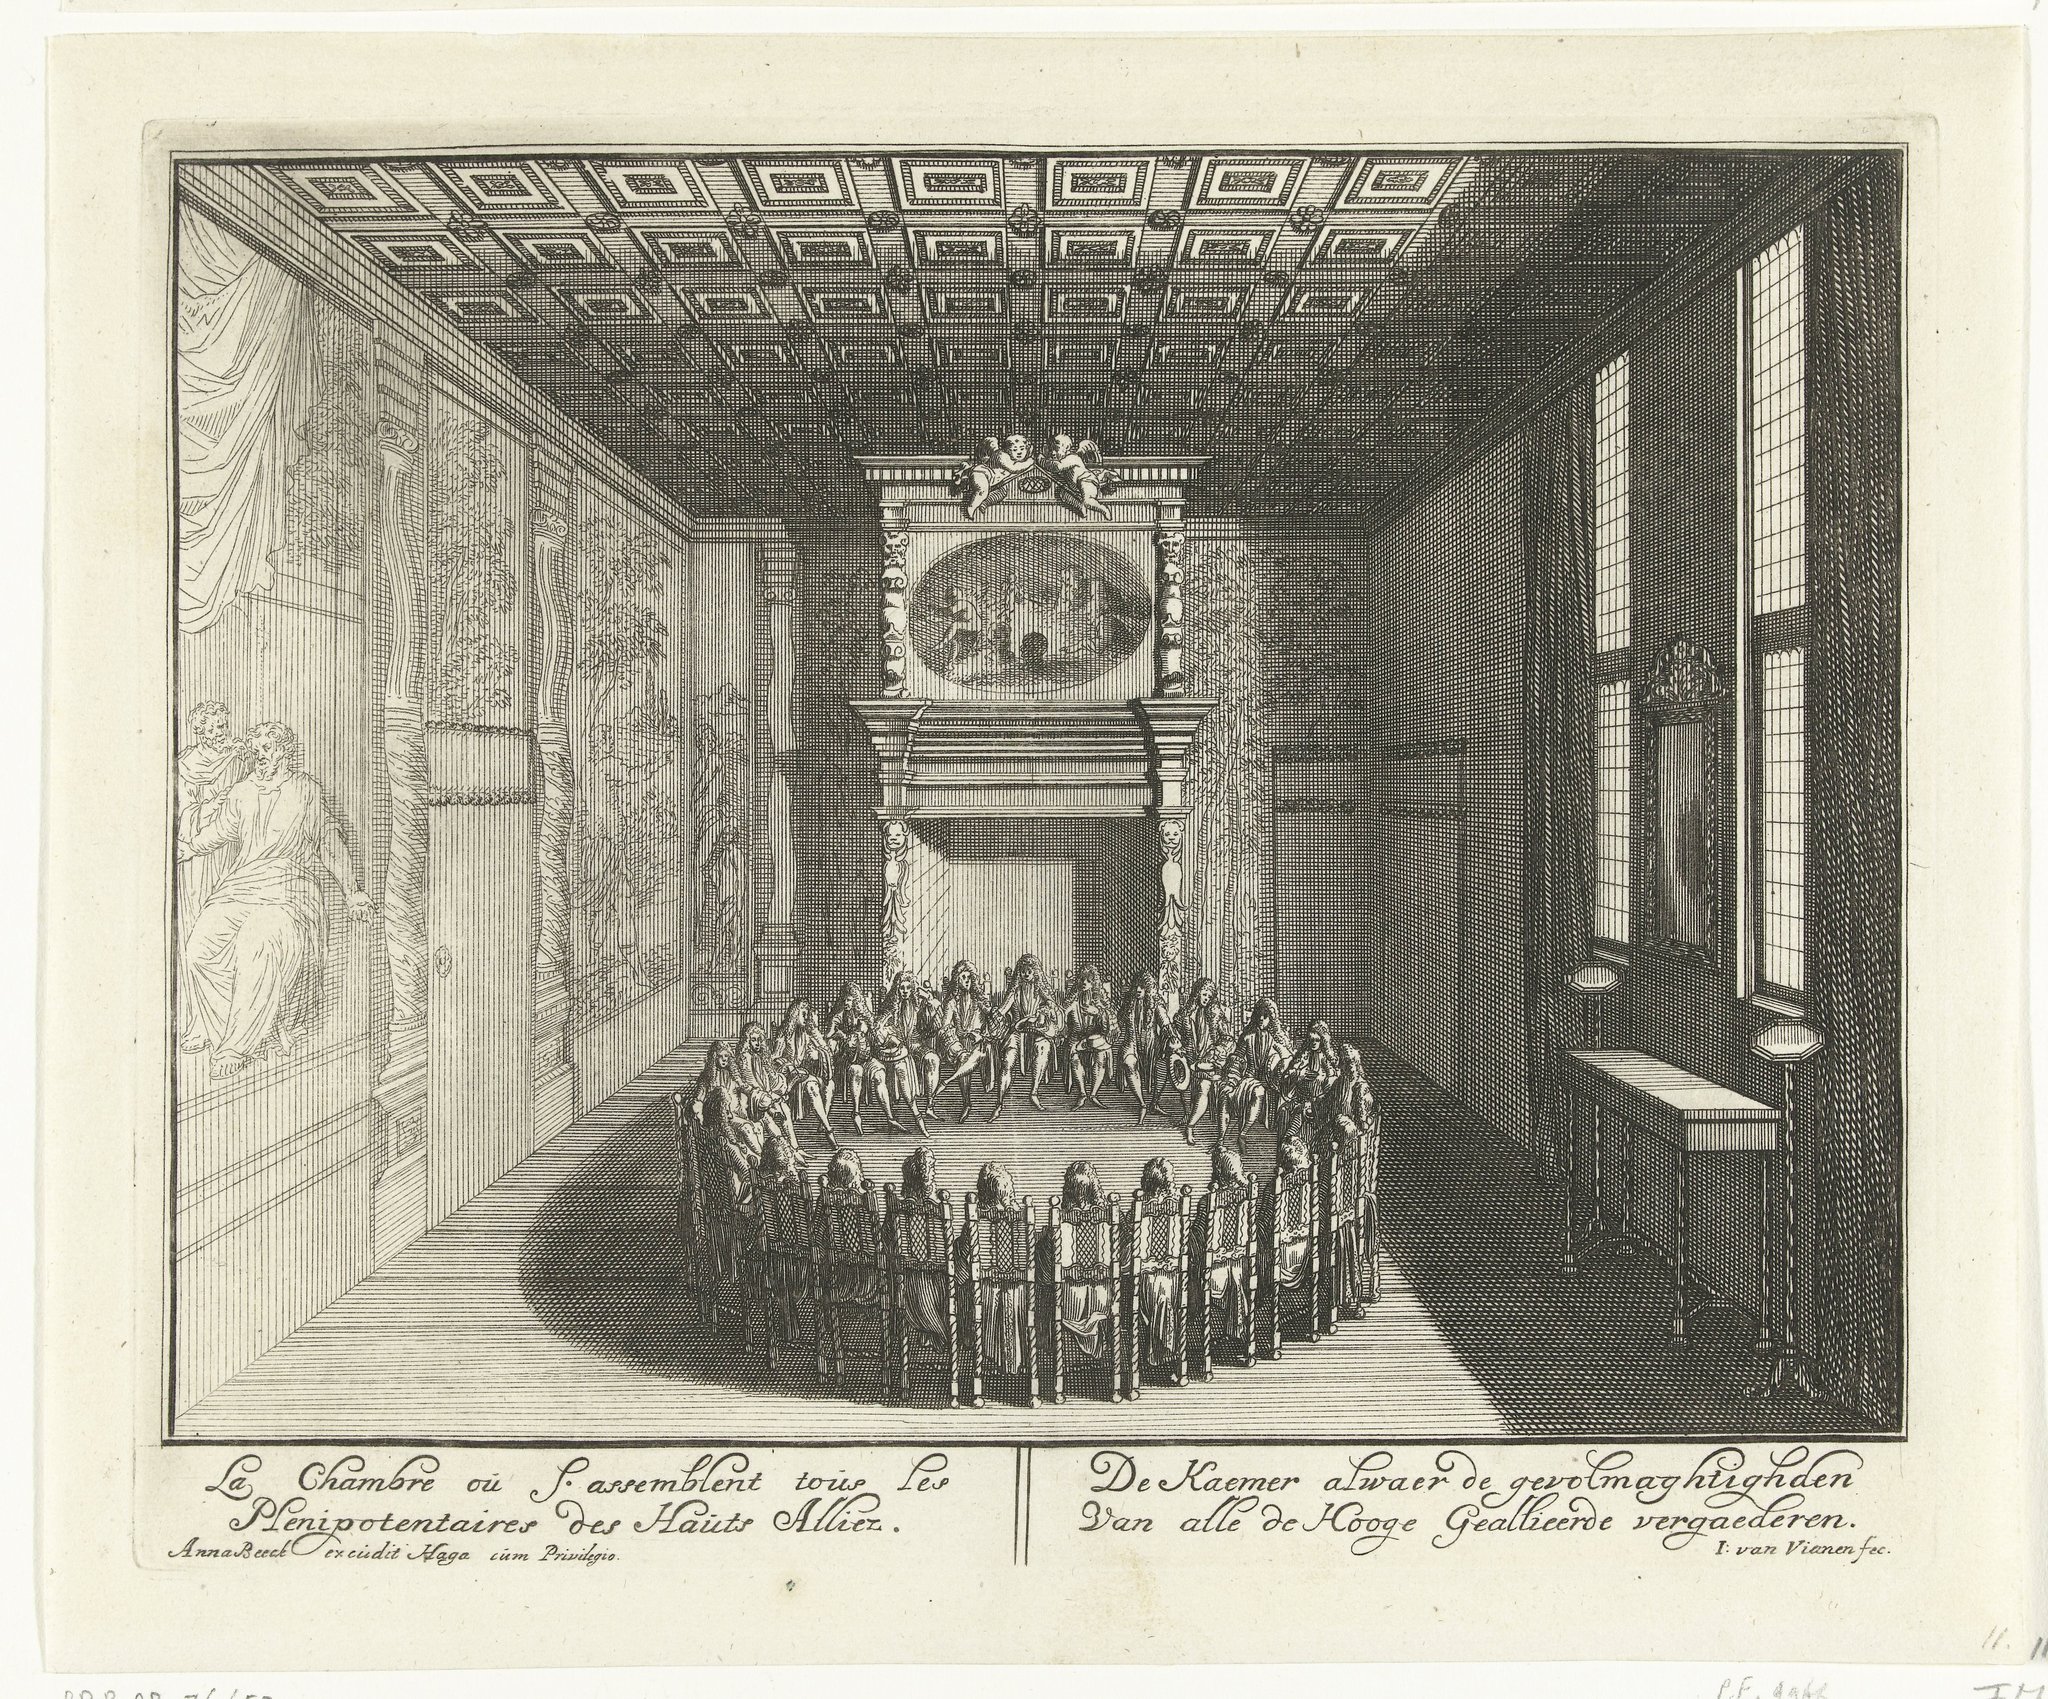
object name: print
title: Kamer van de gevolmachtigden van de geallieerden in het Huis ter Nieuburch in Rijswijk, 1697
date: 1697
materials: paper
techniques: etching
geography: northern netherlands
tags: palace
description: De kamer van de gevolmachtigden van de geallieerden in het Huis ter Nieuburch in Rijswijk. Een groep mannen vergaderend gezeten in een kring. In het onderschrift de twee titels in het Frans en Nederlands. Onderdeel (prent 11) van de serie van vijftien prenten over het Huis ter Nieuburch in Rijswijk en de daar gehouden vredesonderhandelingen resulterend in de Vrede van Rijswijk gesloten op 20 september 1697.